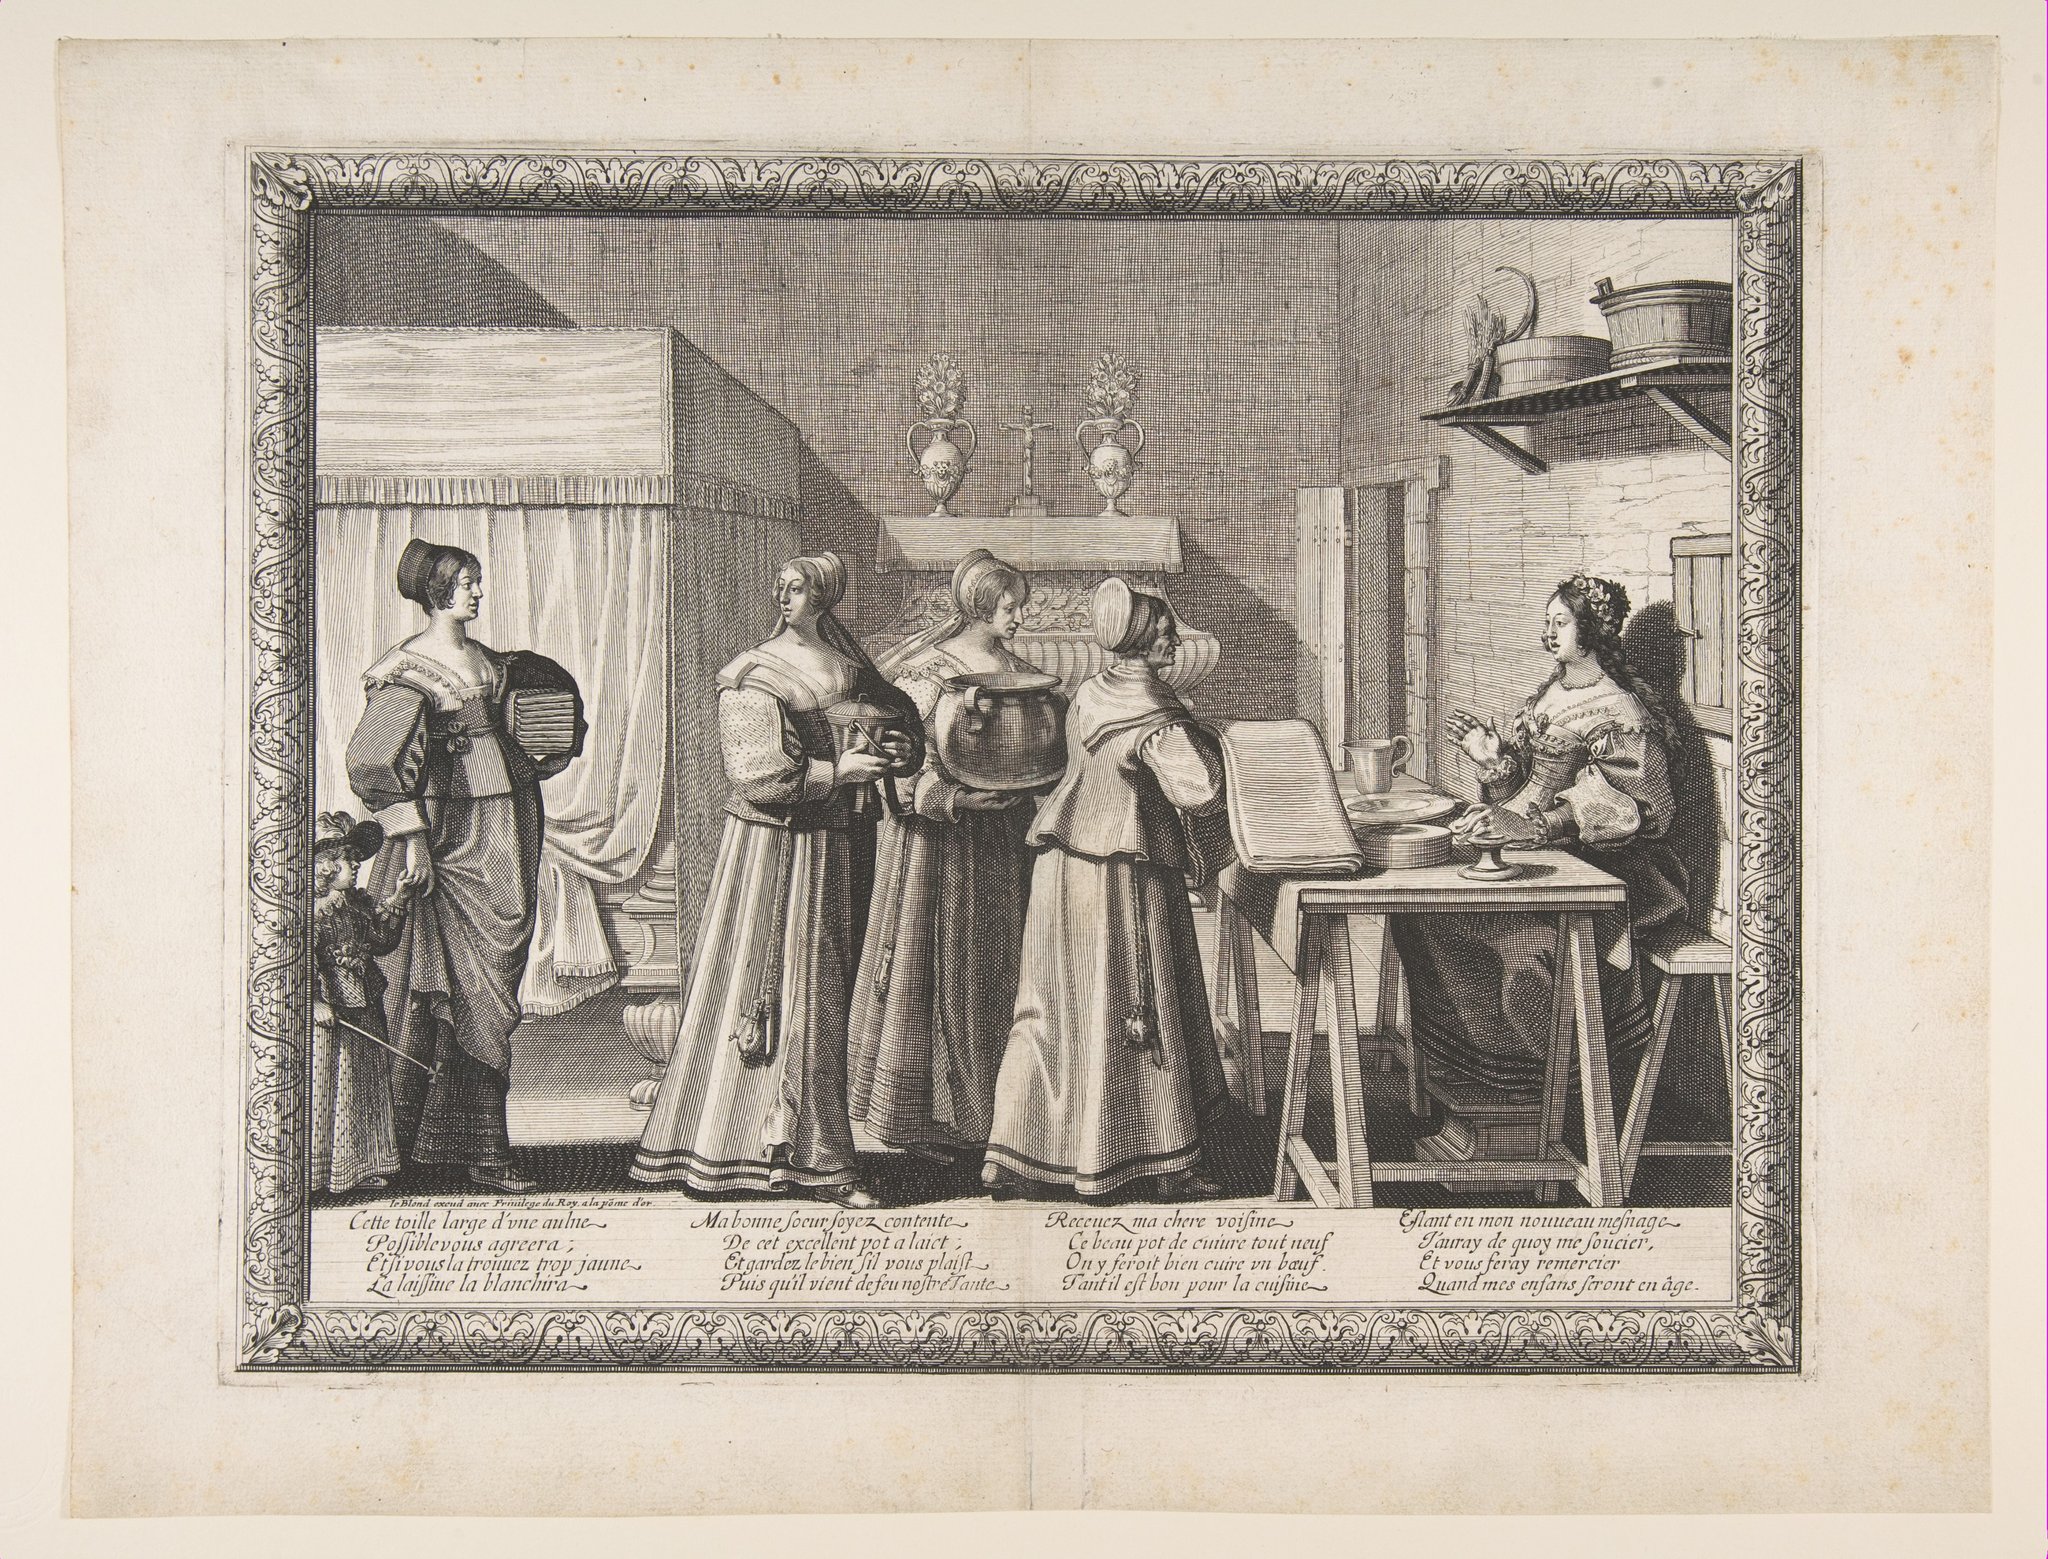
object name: print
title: Presents Offered to the Bride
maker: abraham bosse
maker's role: artist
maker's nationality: french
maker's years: 1602-1676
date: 1633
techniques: etching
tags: interiors,women